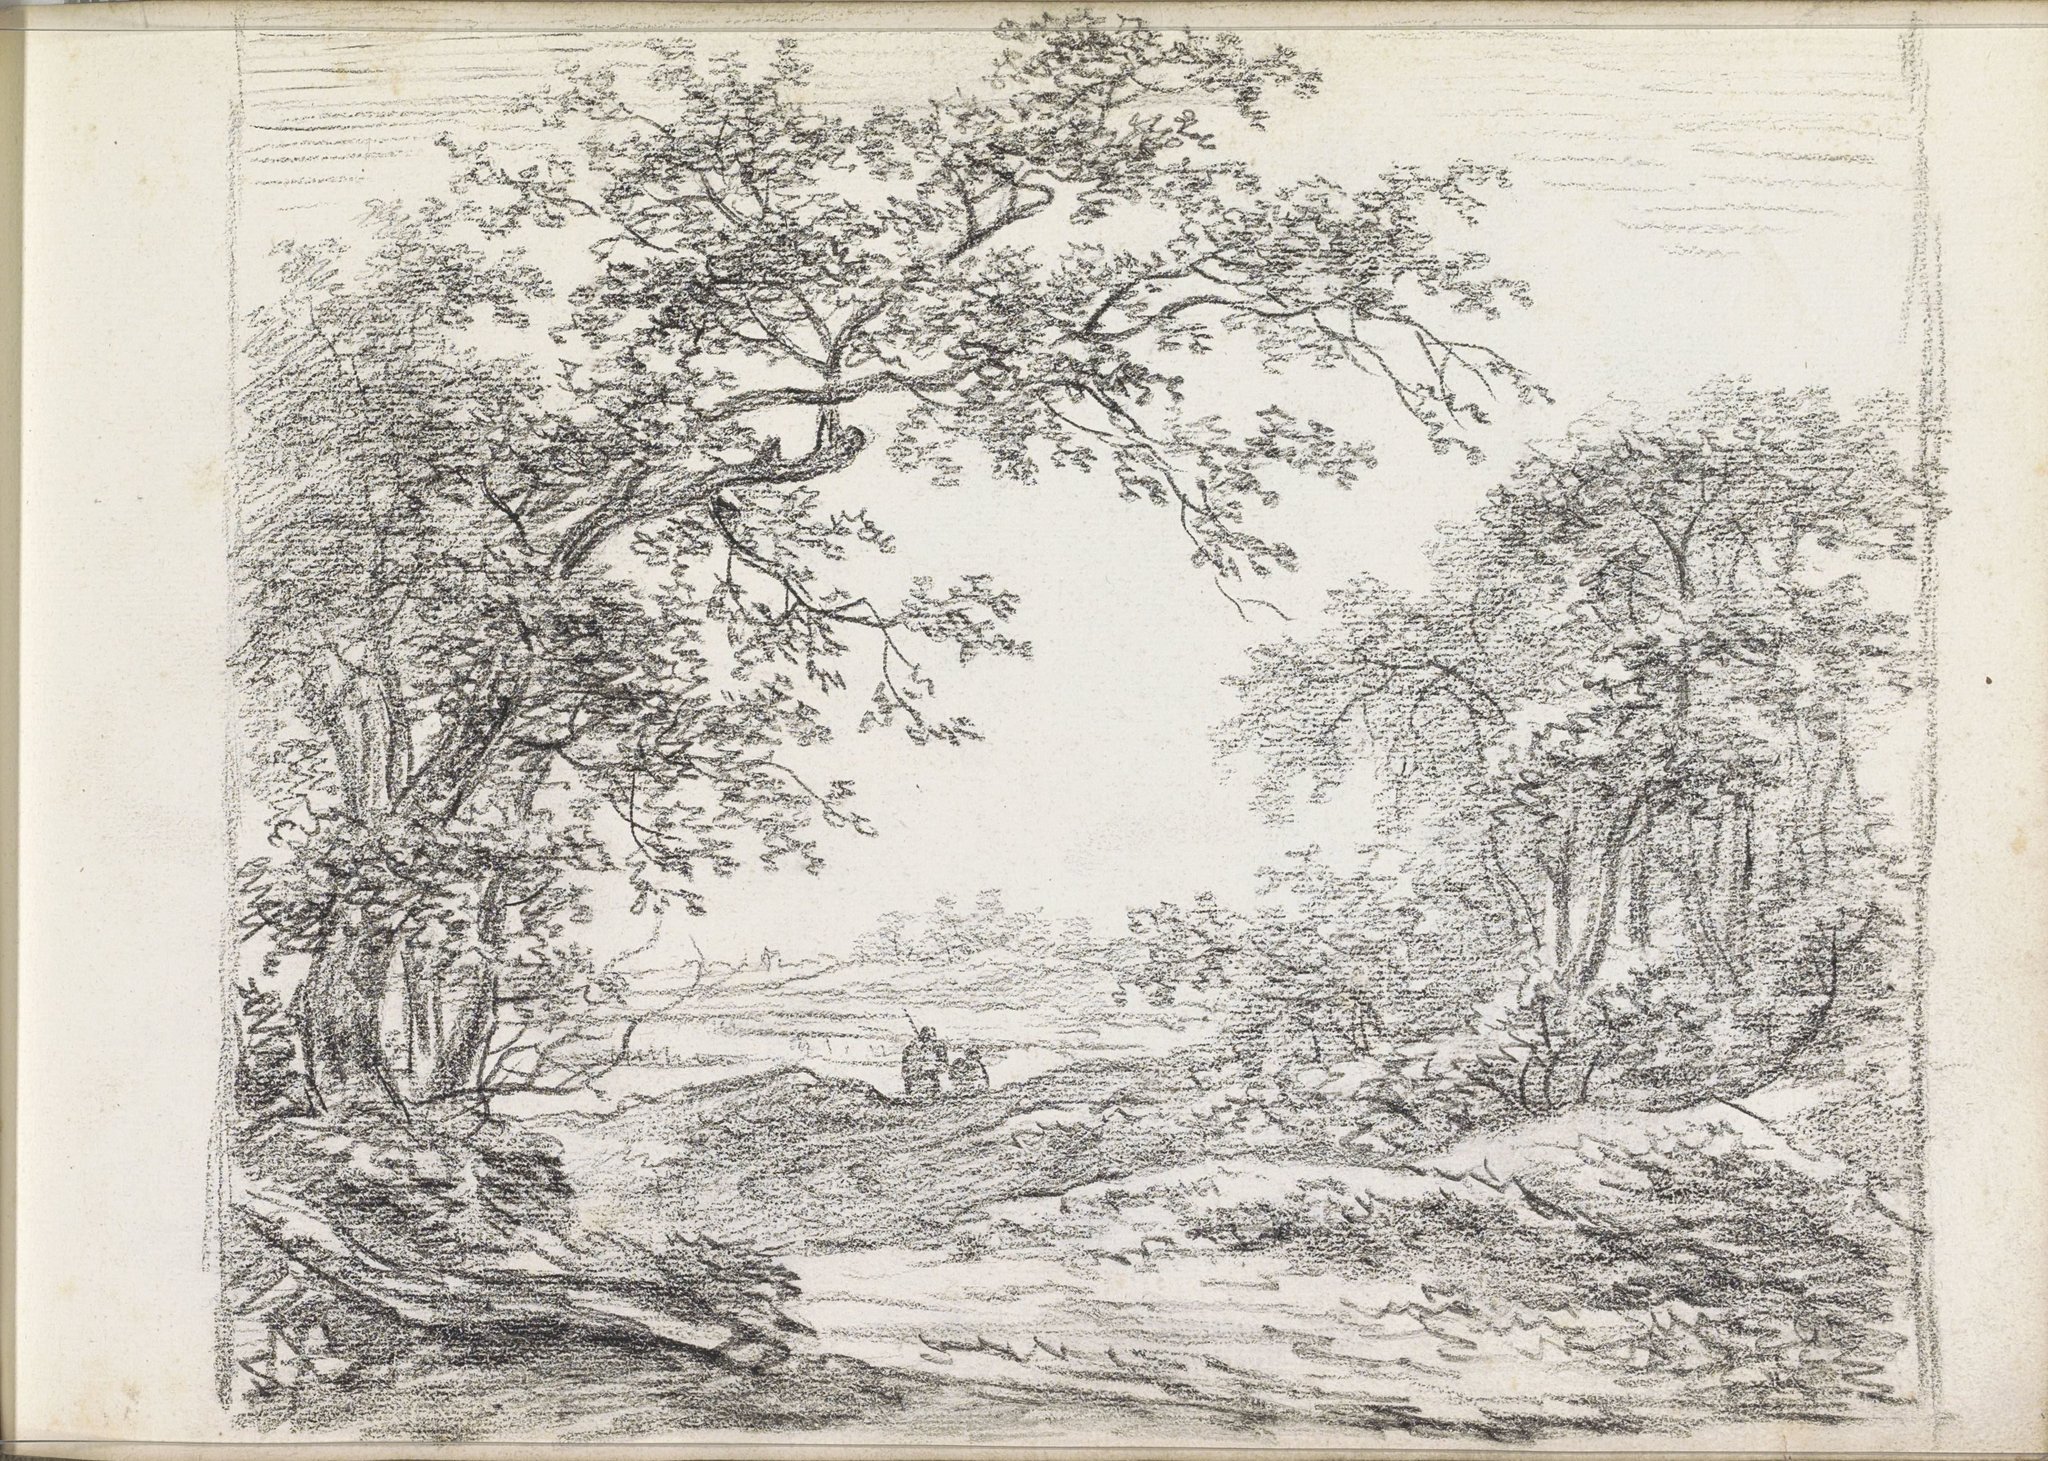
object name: sketchbook leaf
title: Heuvellandschap met bomen en twee figuren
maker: andreas schelfhout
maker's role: draughtsman, painter, print maker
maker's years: 1787-1870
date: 1811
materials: chalk, paper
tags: low hill country (+ landscape with figures, staffage)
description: Blad 28 recto uit een schetsboek met 75 bladen.